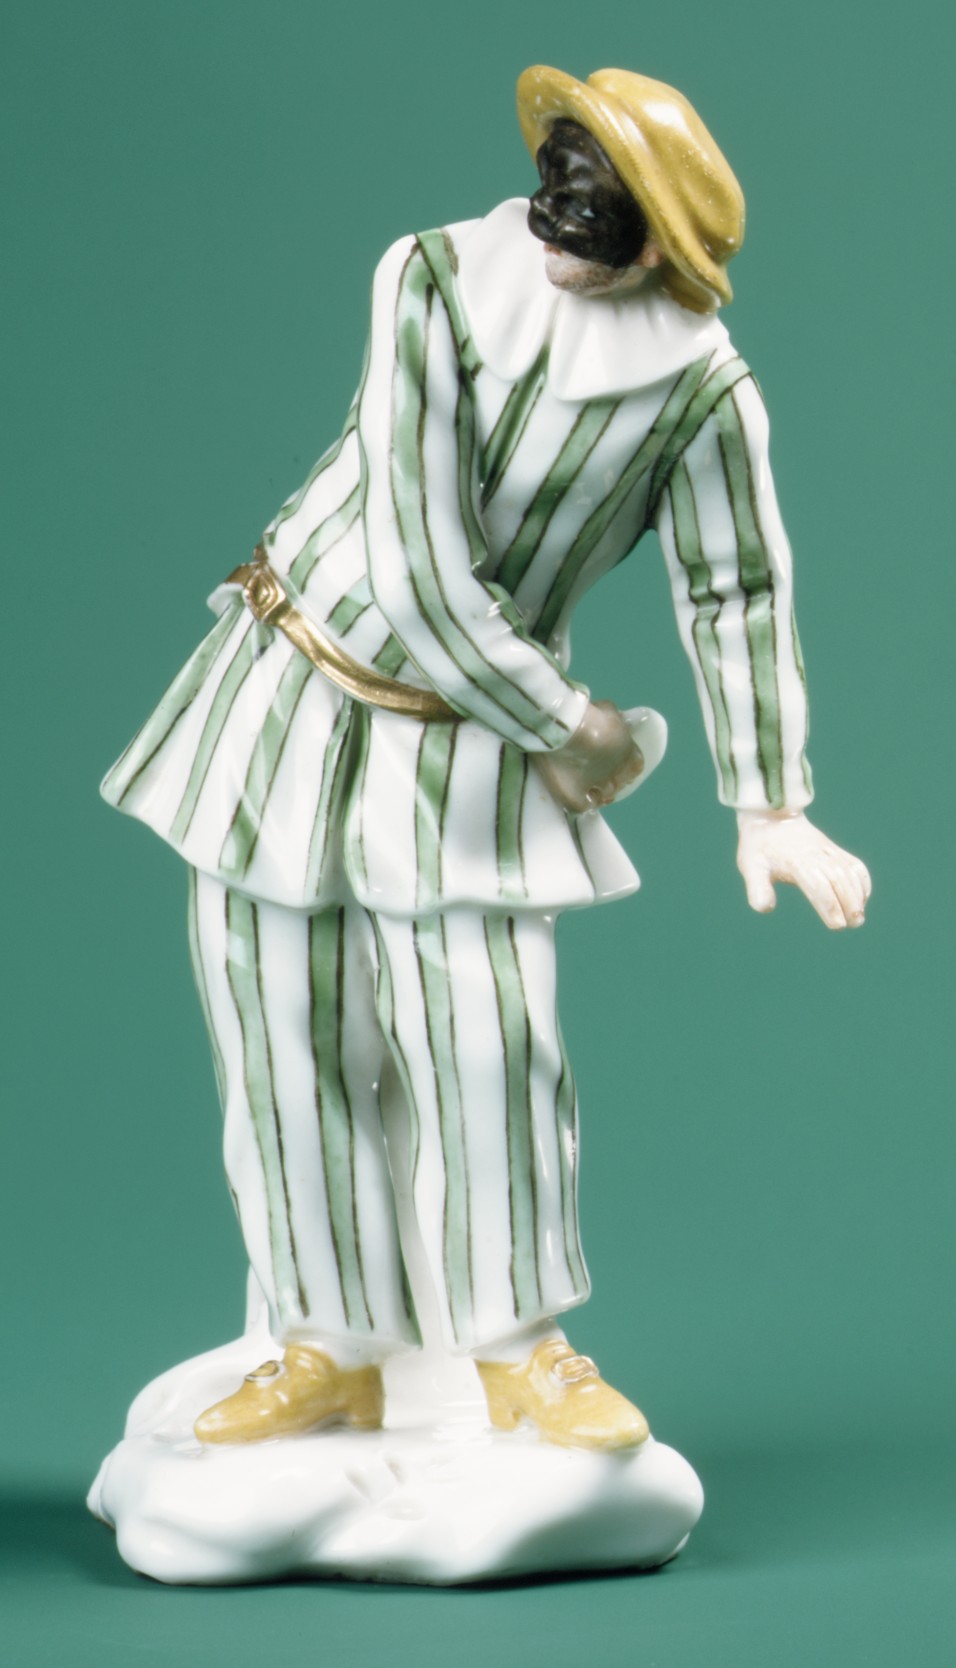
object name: figure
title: Scapin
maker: capodimonte porcelain manufactory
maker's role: manufactory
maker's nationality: italian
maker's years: 1740-1759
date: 1750-1752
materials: soft paste porcelain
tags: men